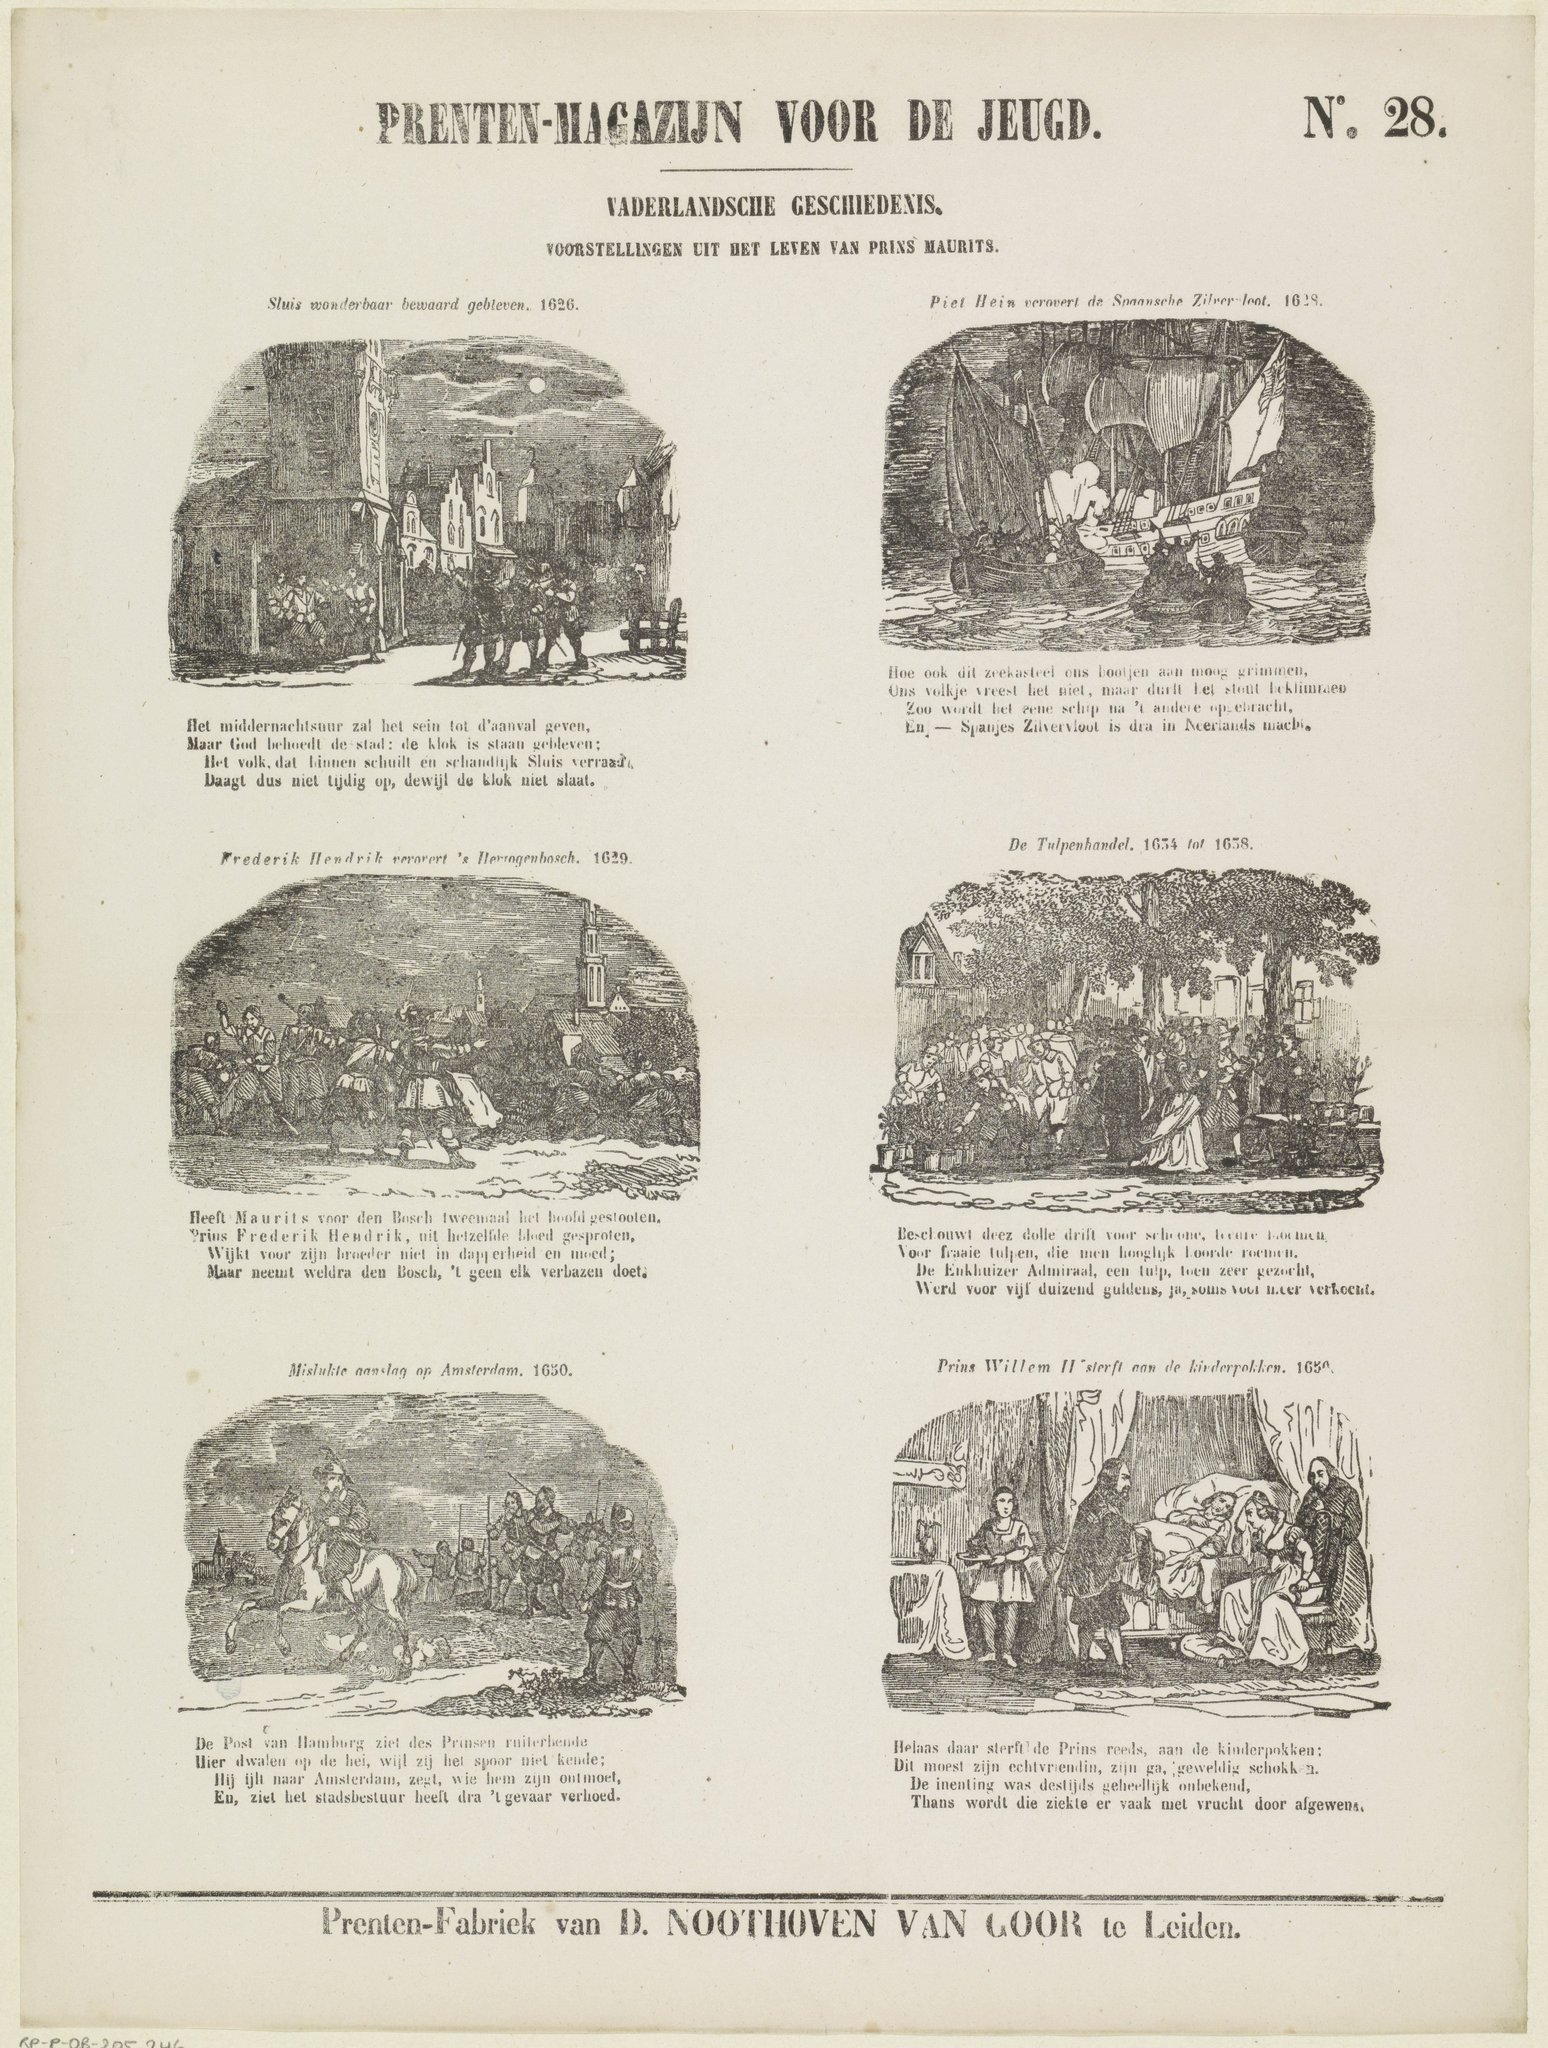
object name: print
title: Voorstellingen uit het leven der prinsen Frederik Hendrik en Willem II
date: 1850-1881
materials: paper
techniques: letterpress printing, engraving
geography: netherlands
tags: delfshaven, william ii (prince of orange), history, den bosch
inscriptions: collector's mark: Lugt 2760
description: Blad met 6 voorstellingen van gebeurtenissen uit de vaderlandse geschiedenis. Boven elke voorstelling een titel en onder elke voorstelling een vierregelig vers. Genummerd rechtsboven: No. 28.